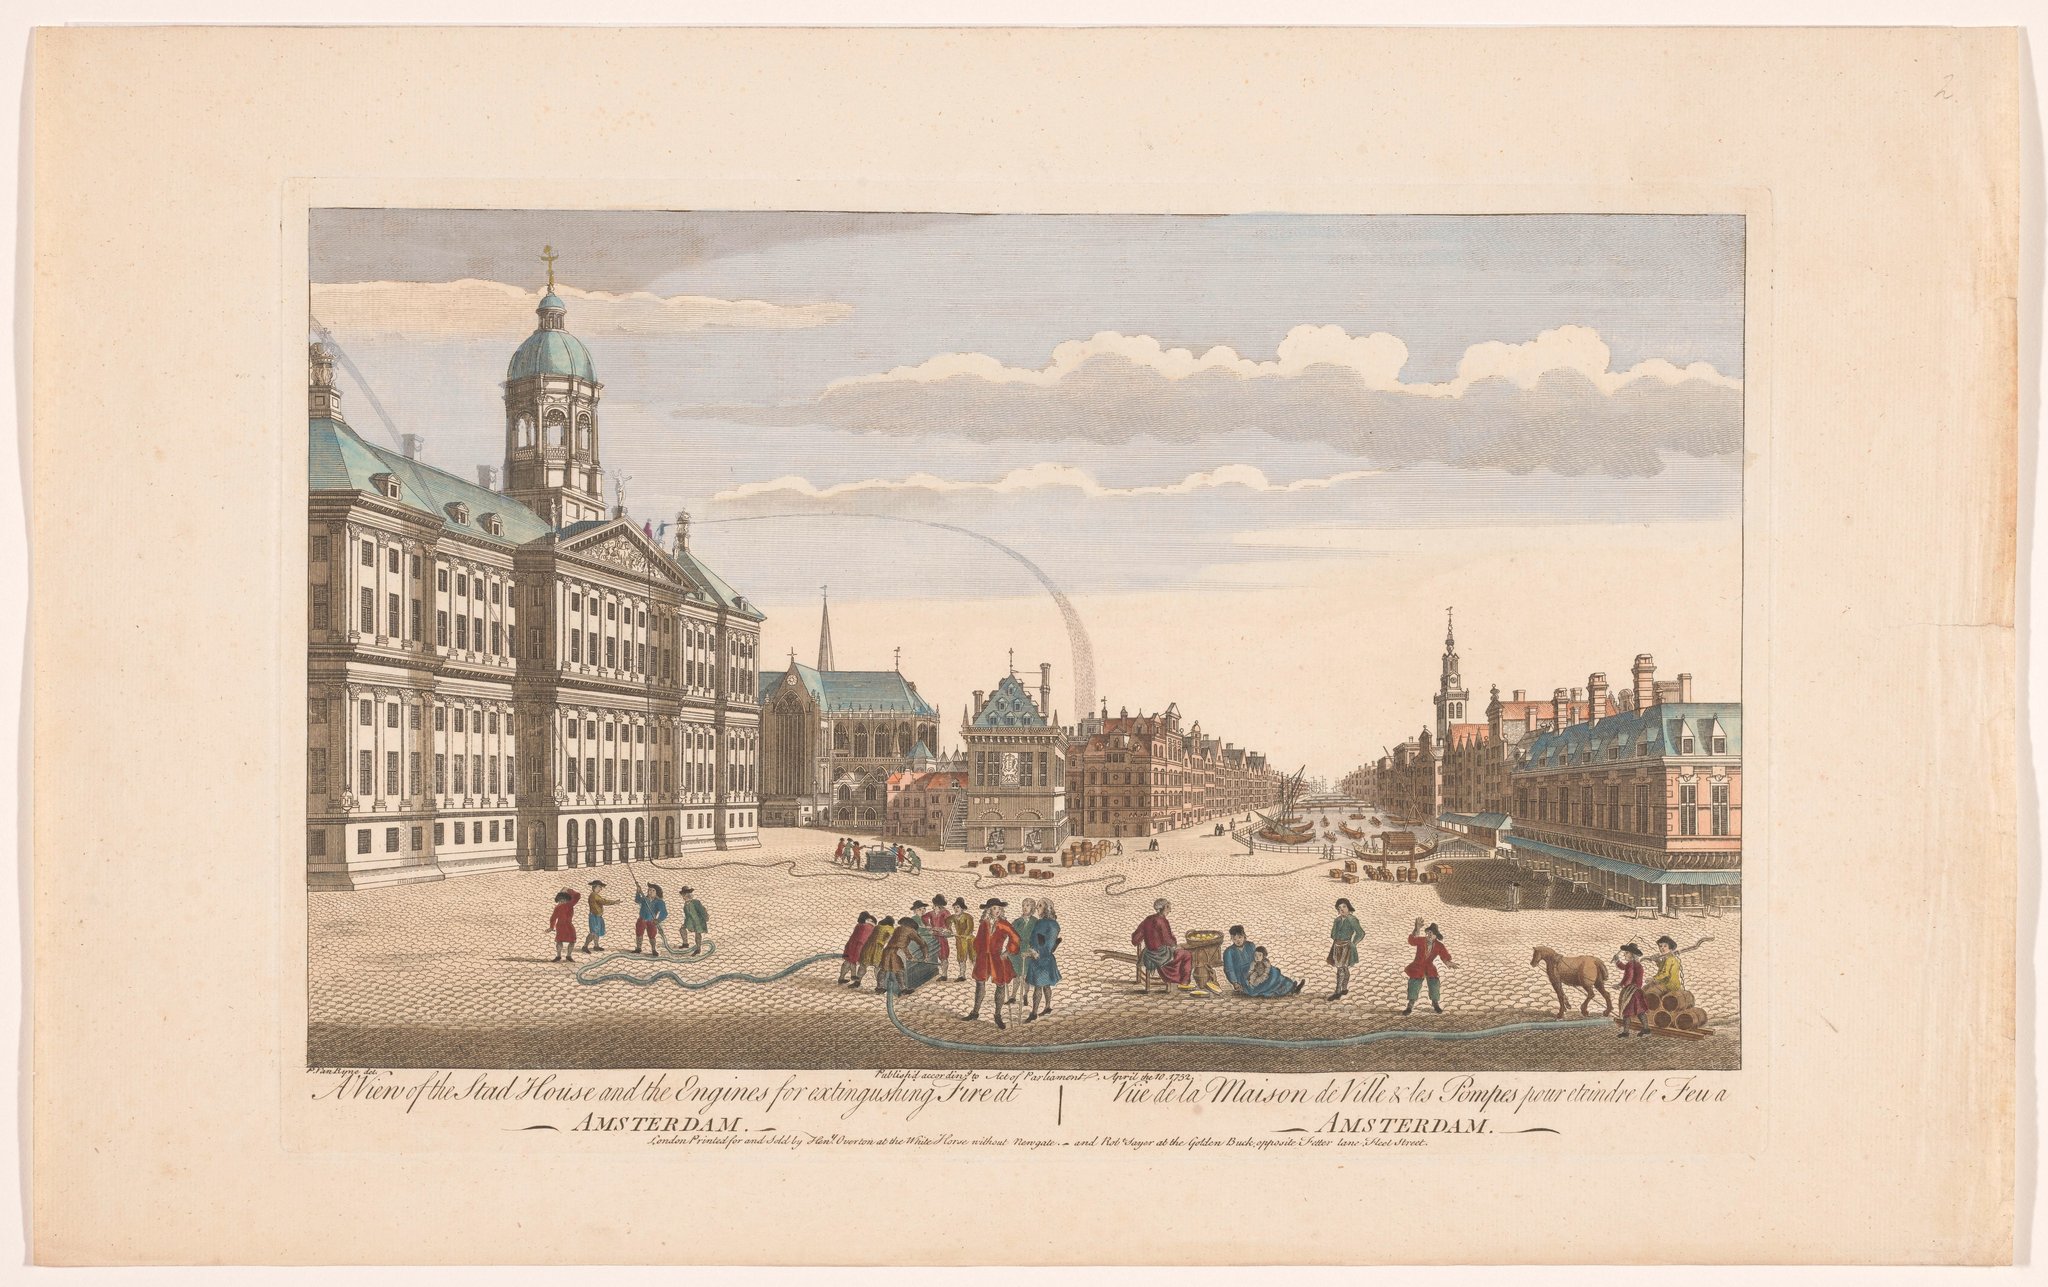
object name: opticaprent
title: A view of the Stad House and the engines for extingushing fire at Amsterdam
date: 1752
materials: paper, watercolor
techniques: brush, etching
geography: london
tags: townhall, firemen, square, place, circus, etc. (+ city(-scape) with figures, staffage)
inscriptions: watermark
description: De serie “Holland” bevat negen prenten met de nummers 1-9, waarvan dit nummer 2 is.